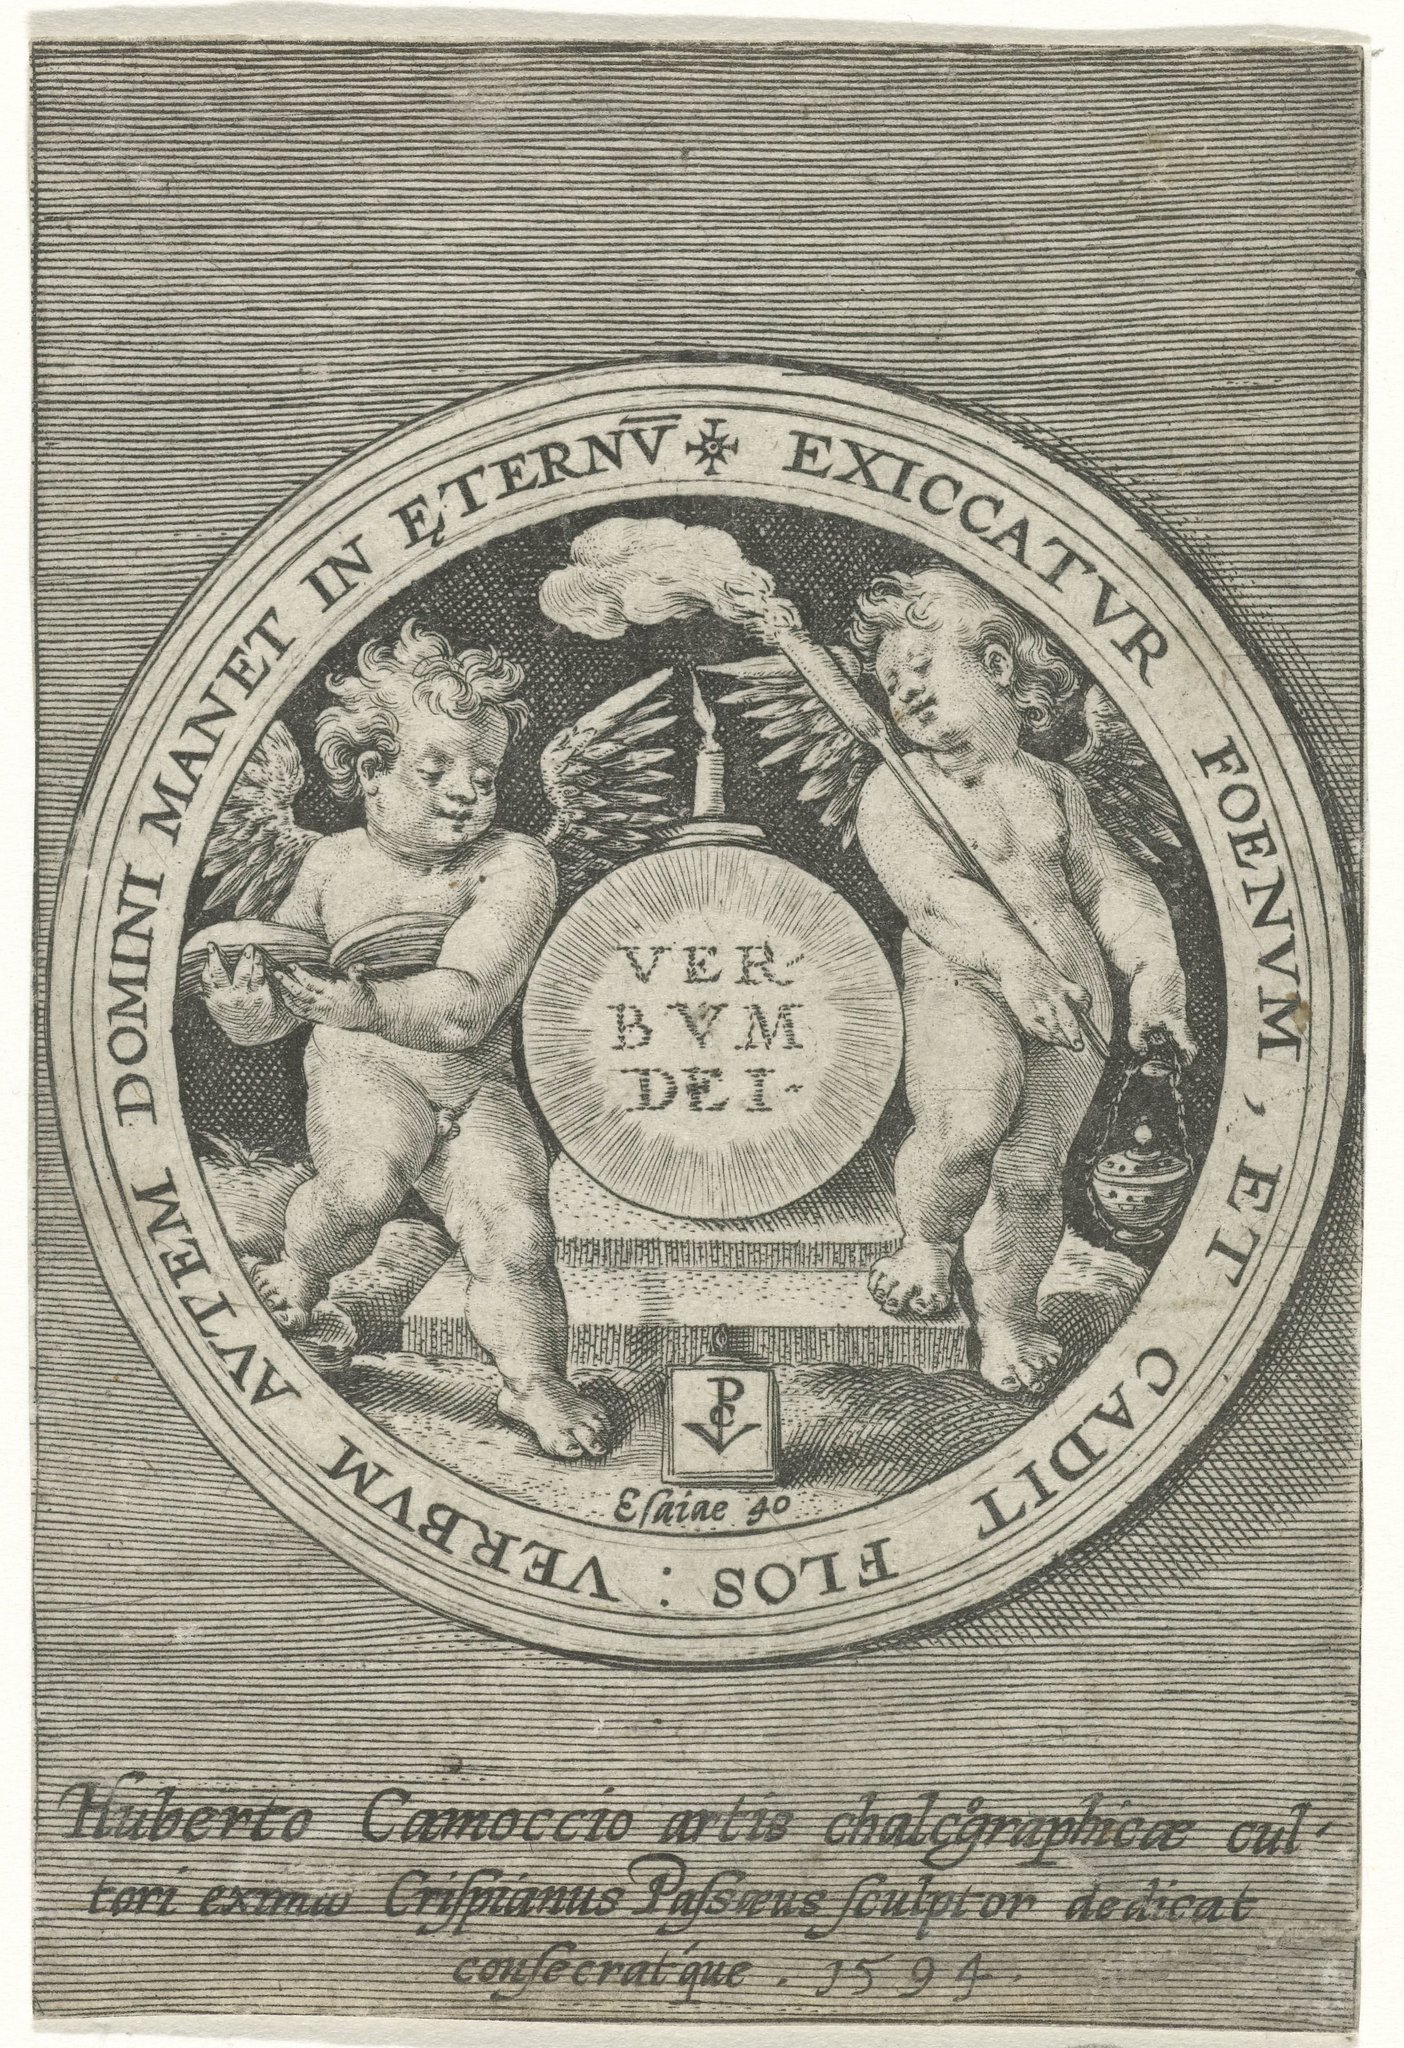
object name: print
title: Medaillon met twee putti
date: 1594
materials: paper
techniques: engraving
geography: cologne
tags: angel(s) with censer, angel(s) with torch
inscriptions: date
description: Medaillon met twee putti die een opengeslagen boek en een brandende fakkel en een wierookvat vasthouden. Tussen hen in de serietitel in het Latijn. De prent heeft een omlijsting met een randschrift in het Latijn.